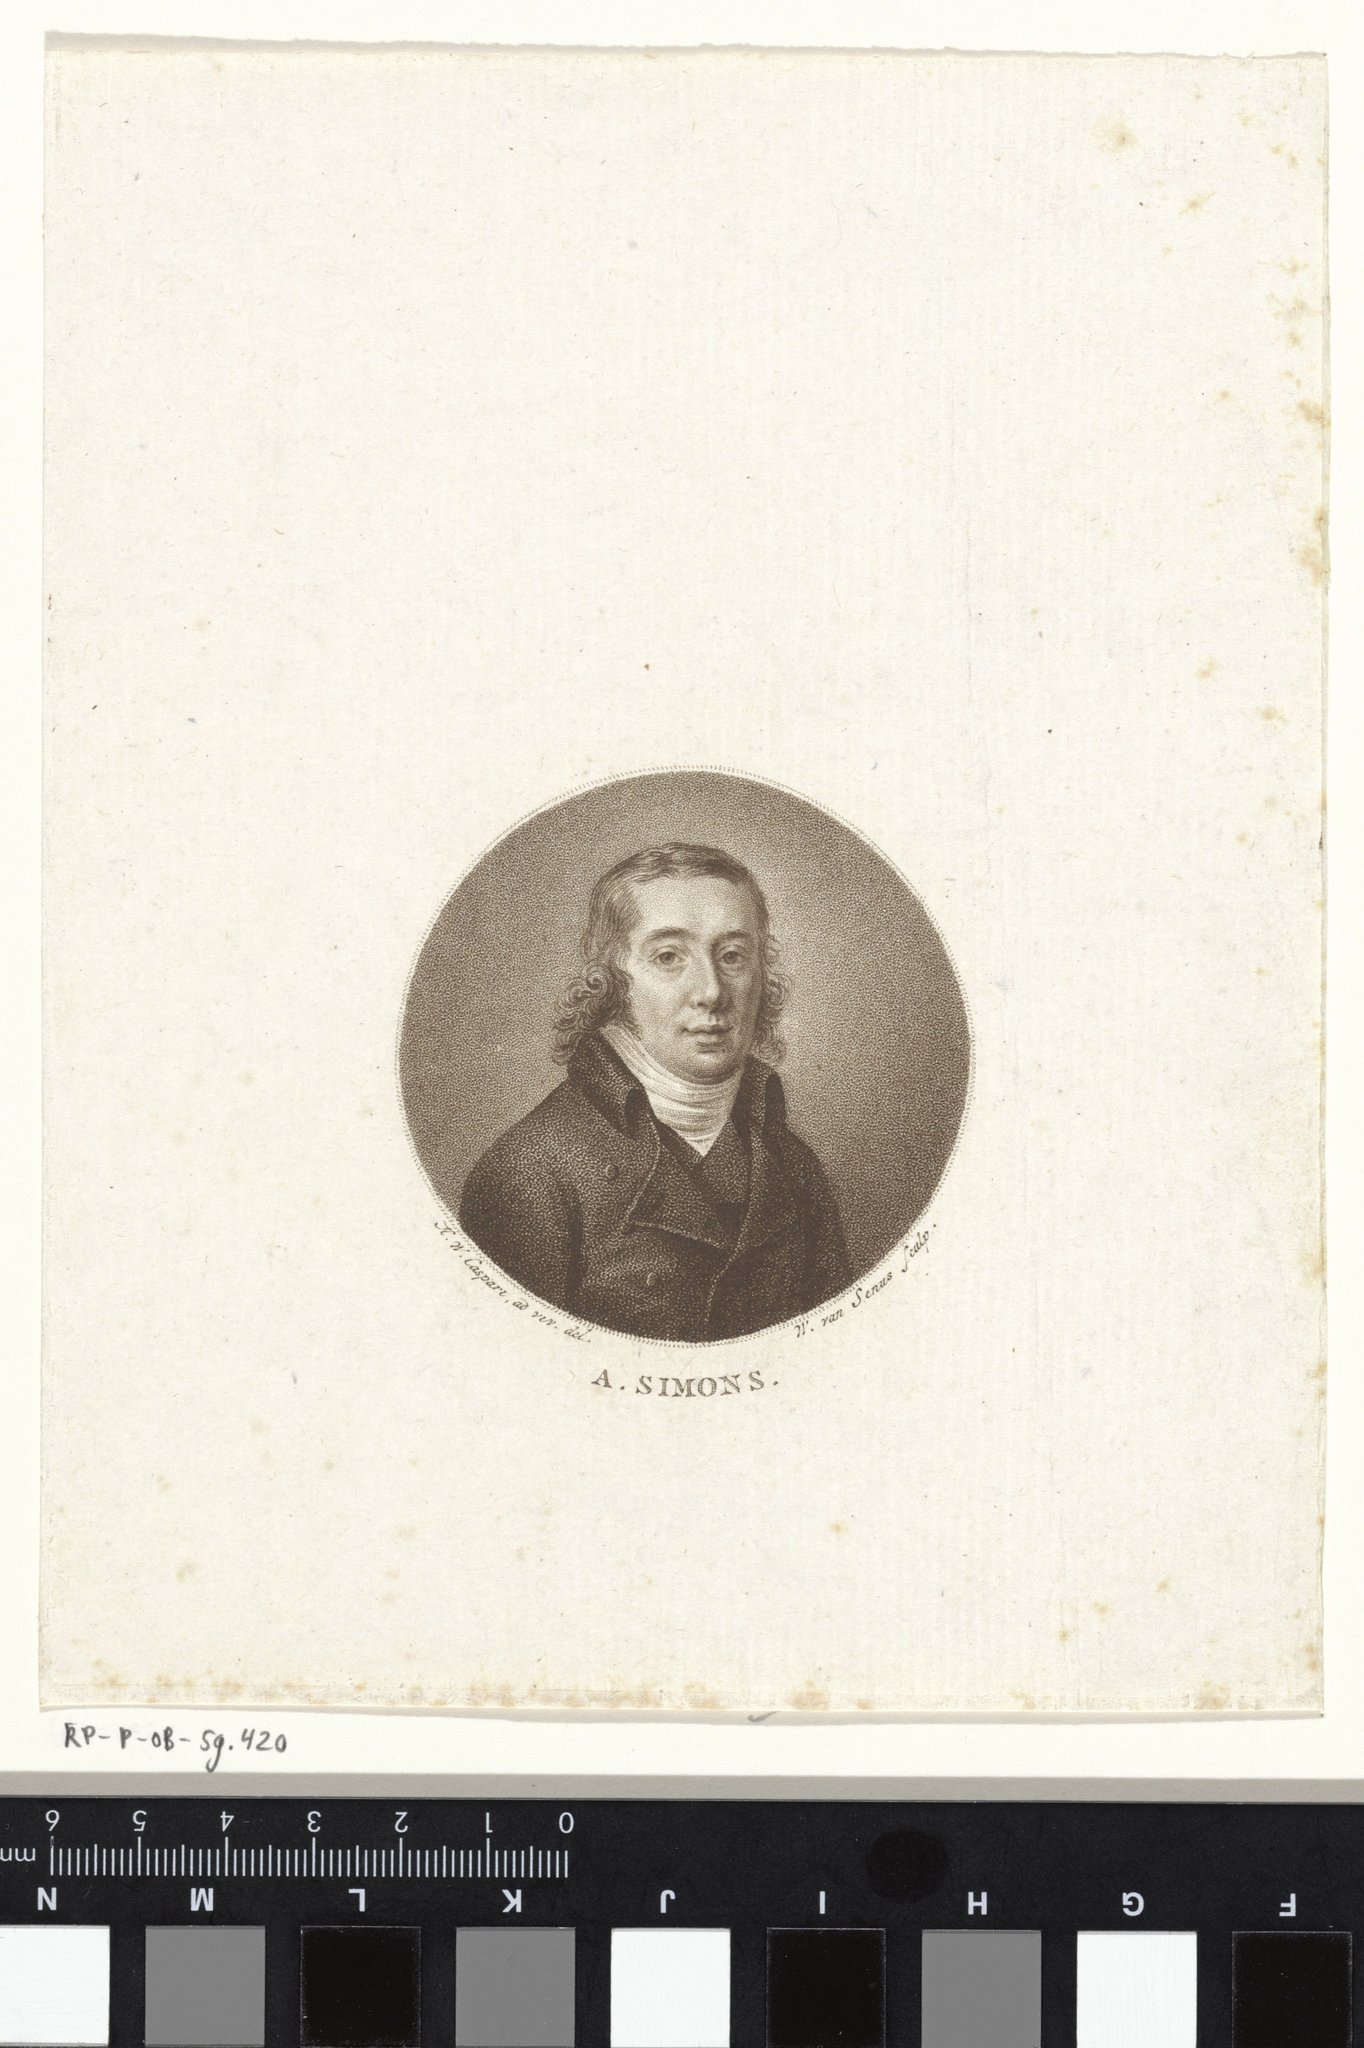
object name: print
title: Portret van de dichter Adam Simons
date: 1805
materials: paper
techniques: printing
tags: adam simons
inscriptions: collector's mark: Lugt 2228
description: Prent gebruikt op titelpagina van: Simons, Adam. Gedichten. Amsterdam: J. ten Brink Gerritsz., 1805.